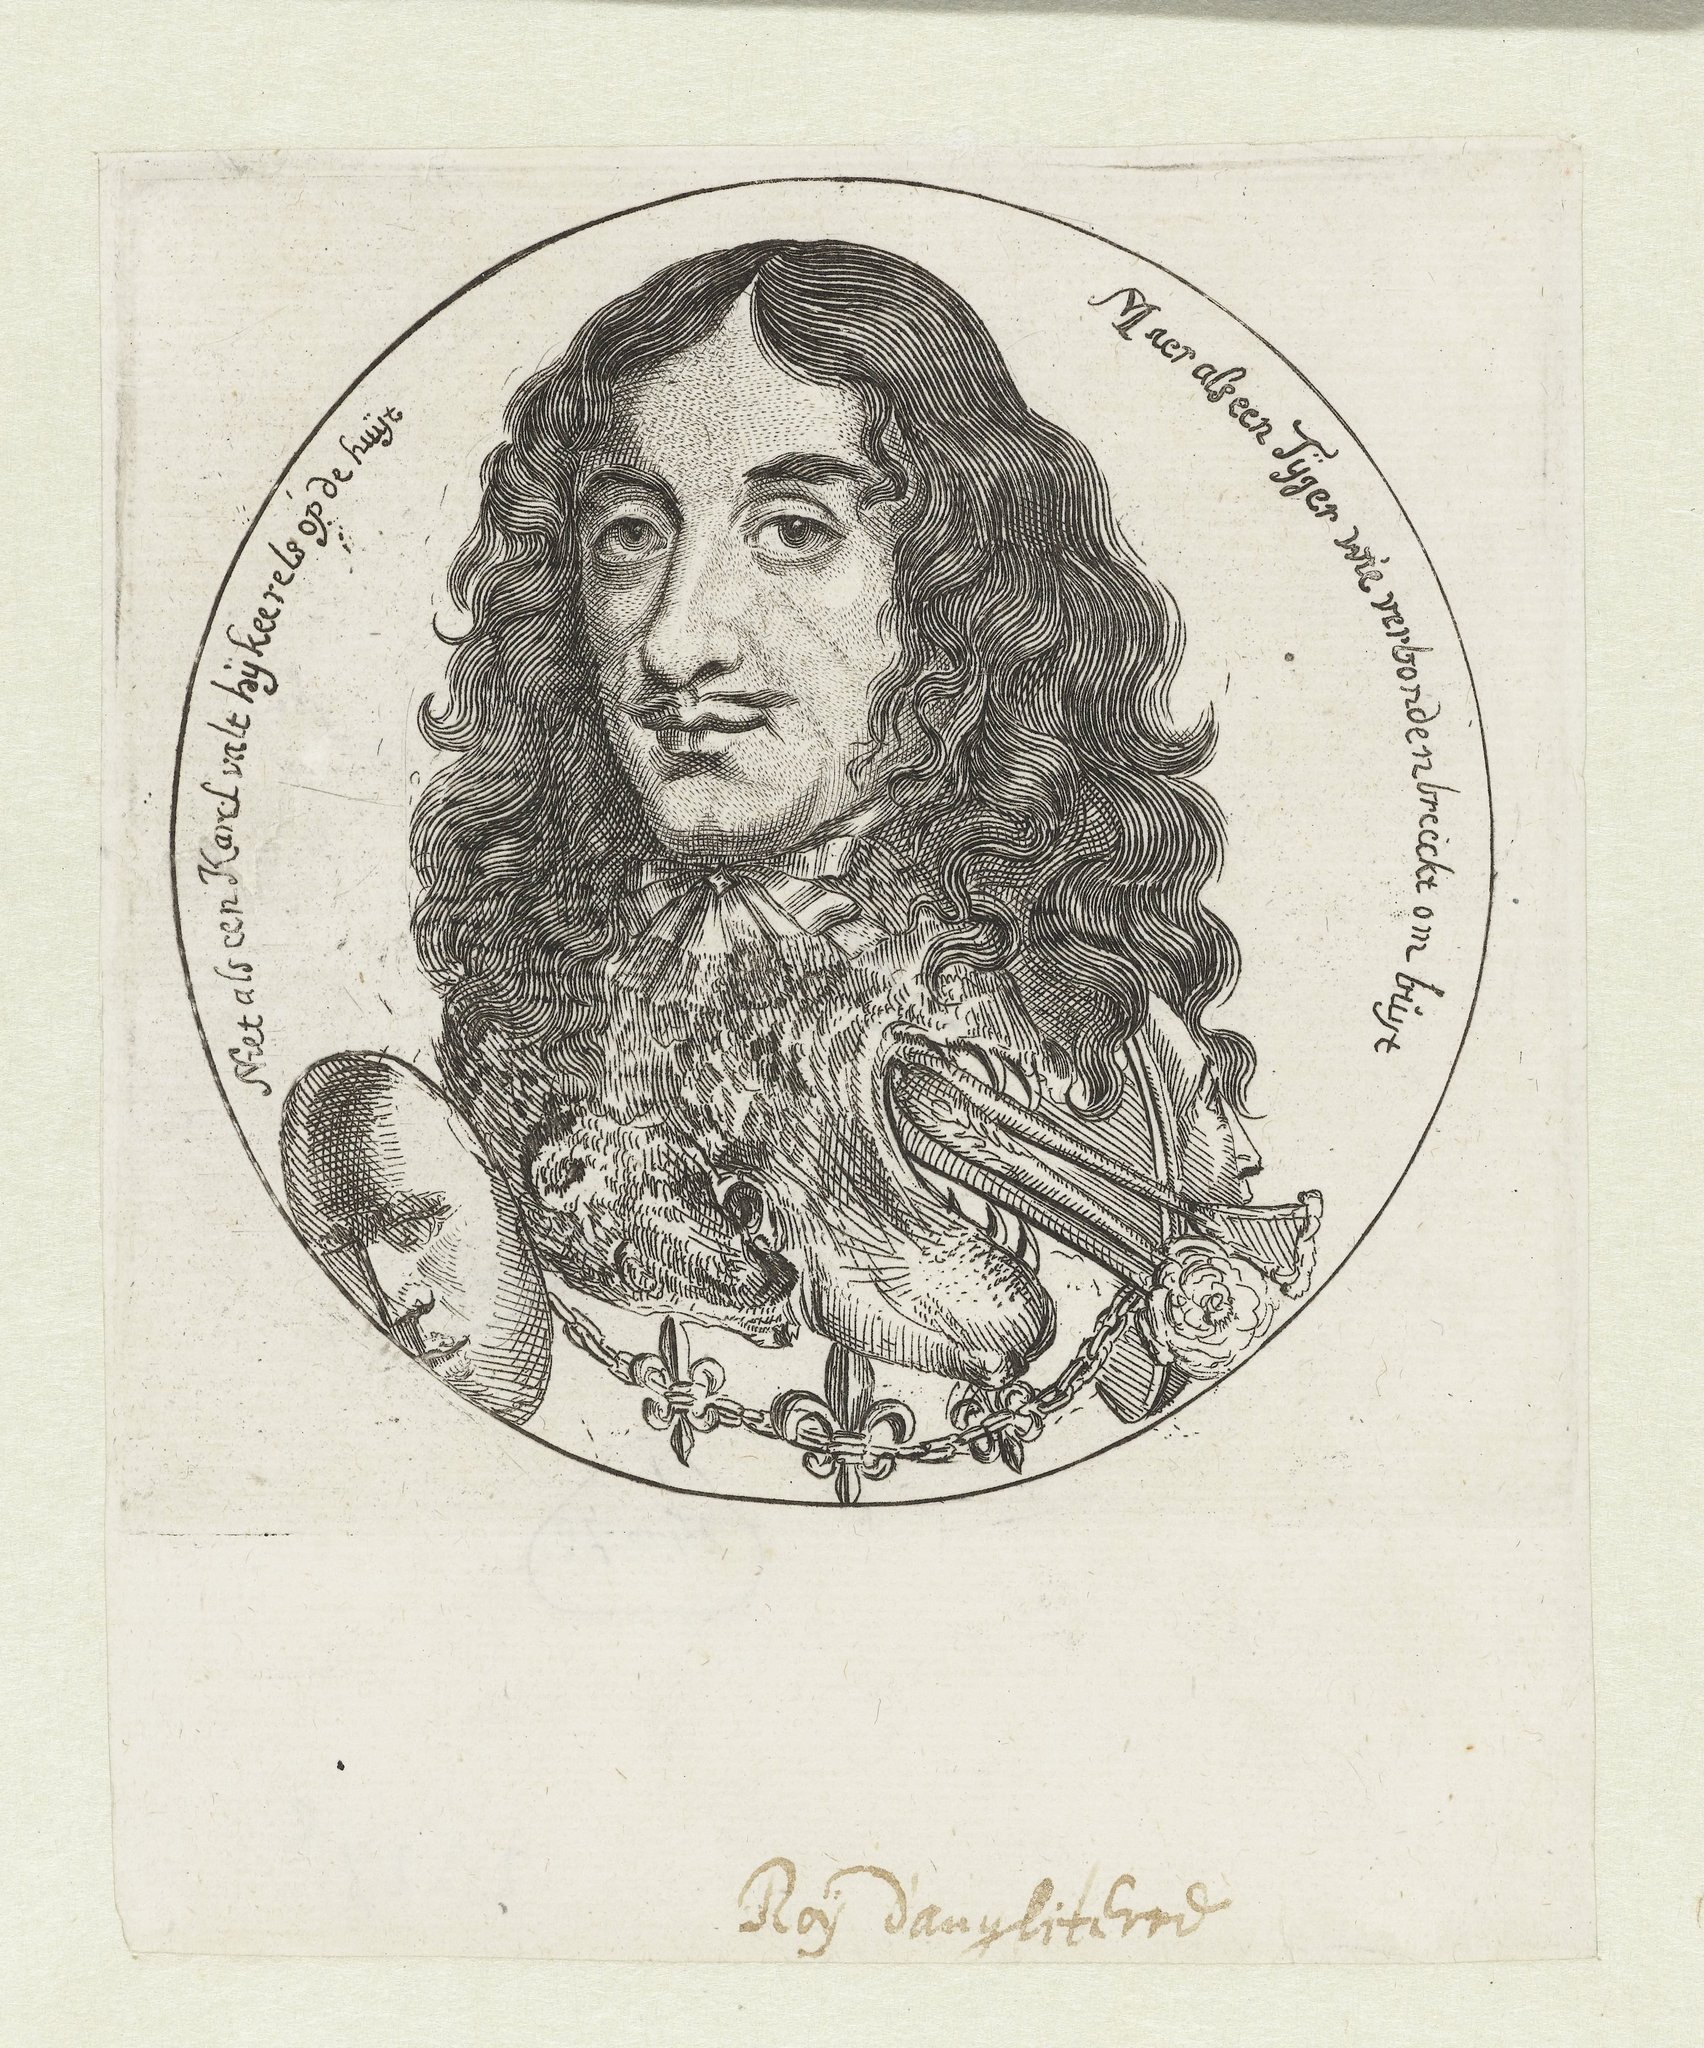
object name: print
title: Double heads of protagonists in the Year of Disasters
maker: romeyn de hooghe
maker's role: draughtsman, goldsmith, painter, print maker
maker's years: 1645-1708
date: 1672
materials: paper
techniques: engraving, etching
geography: northern netherlands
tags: london, karel ii (koning van engeland), rampjaar (disaster year)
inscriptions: inscription: ‘Net als een Karel valt hij de keerels op de huijt / Maer als een Tijger wie verbonden breeckt om buyt.’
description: In 1672, known as the ‘Year of Disasters’, the Dutch Republic came under simultaneous attack by France, England and Germany. The double heads depict the protagonists, whose true nature is revealed when they are turned upside down. From left to right, they are: Stadtholder William III as Mars, Louis XIV as a lion, the English King Charles II as a tiger, Archbishop Henry of Bavaria as an ass and the Bishop of Munster as a swine. Johan and Cornelis de Witt are a fox and a wolf. Many believed they were to blame for the war.